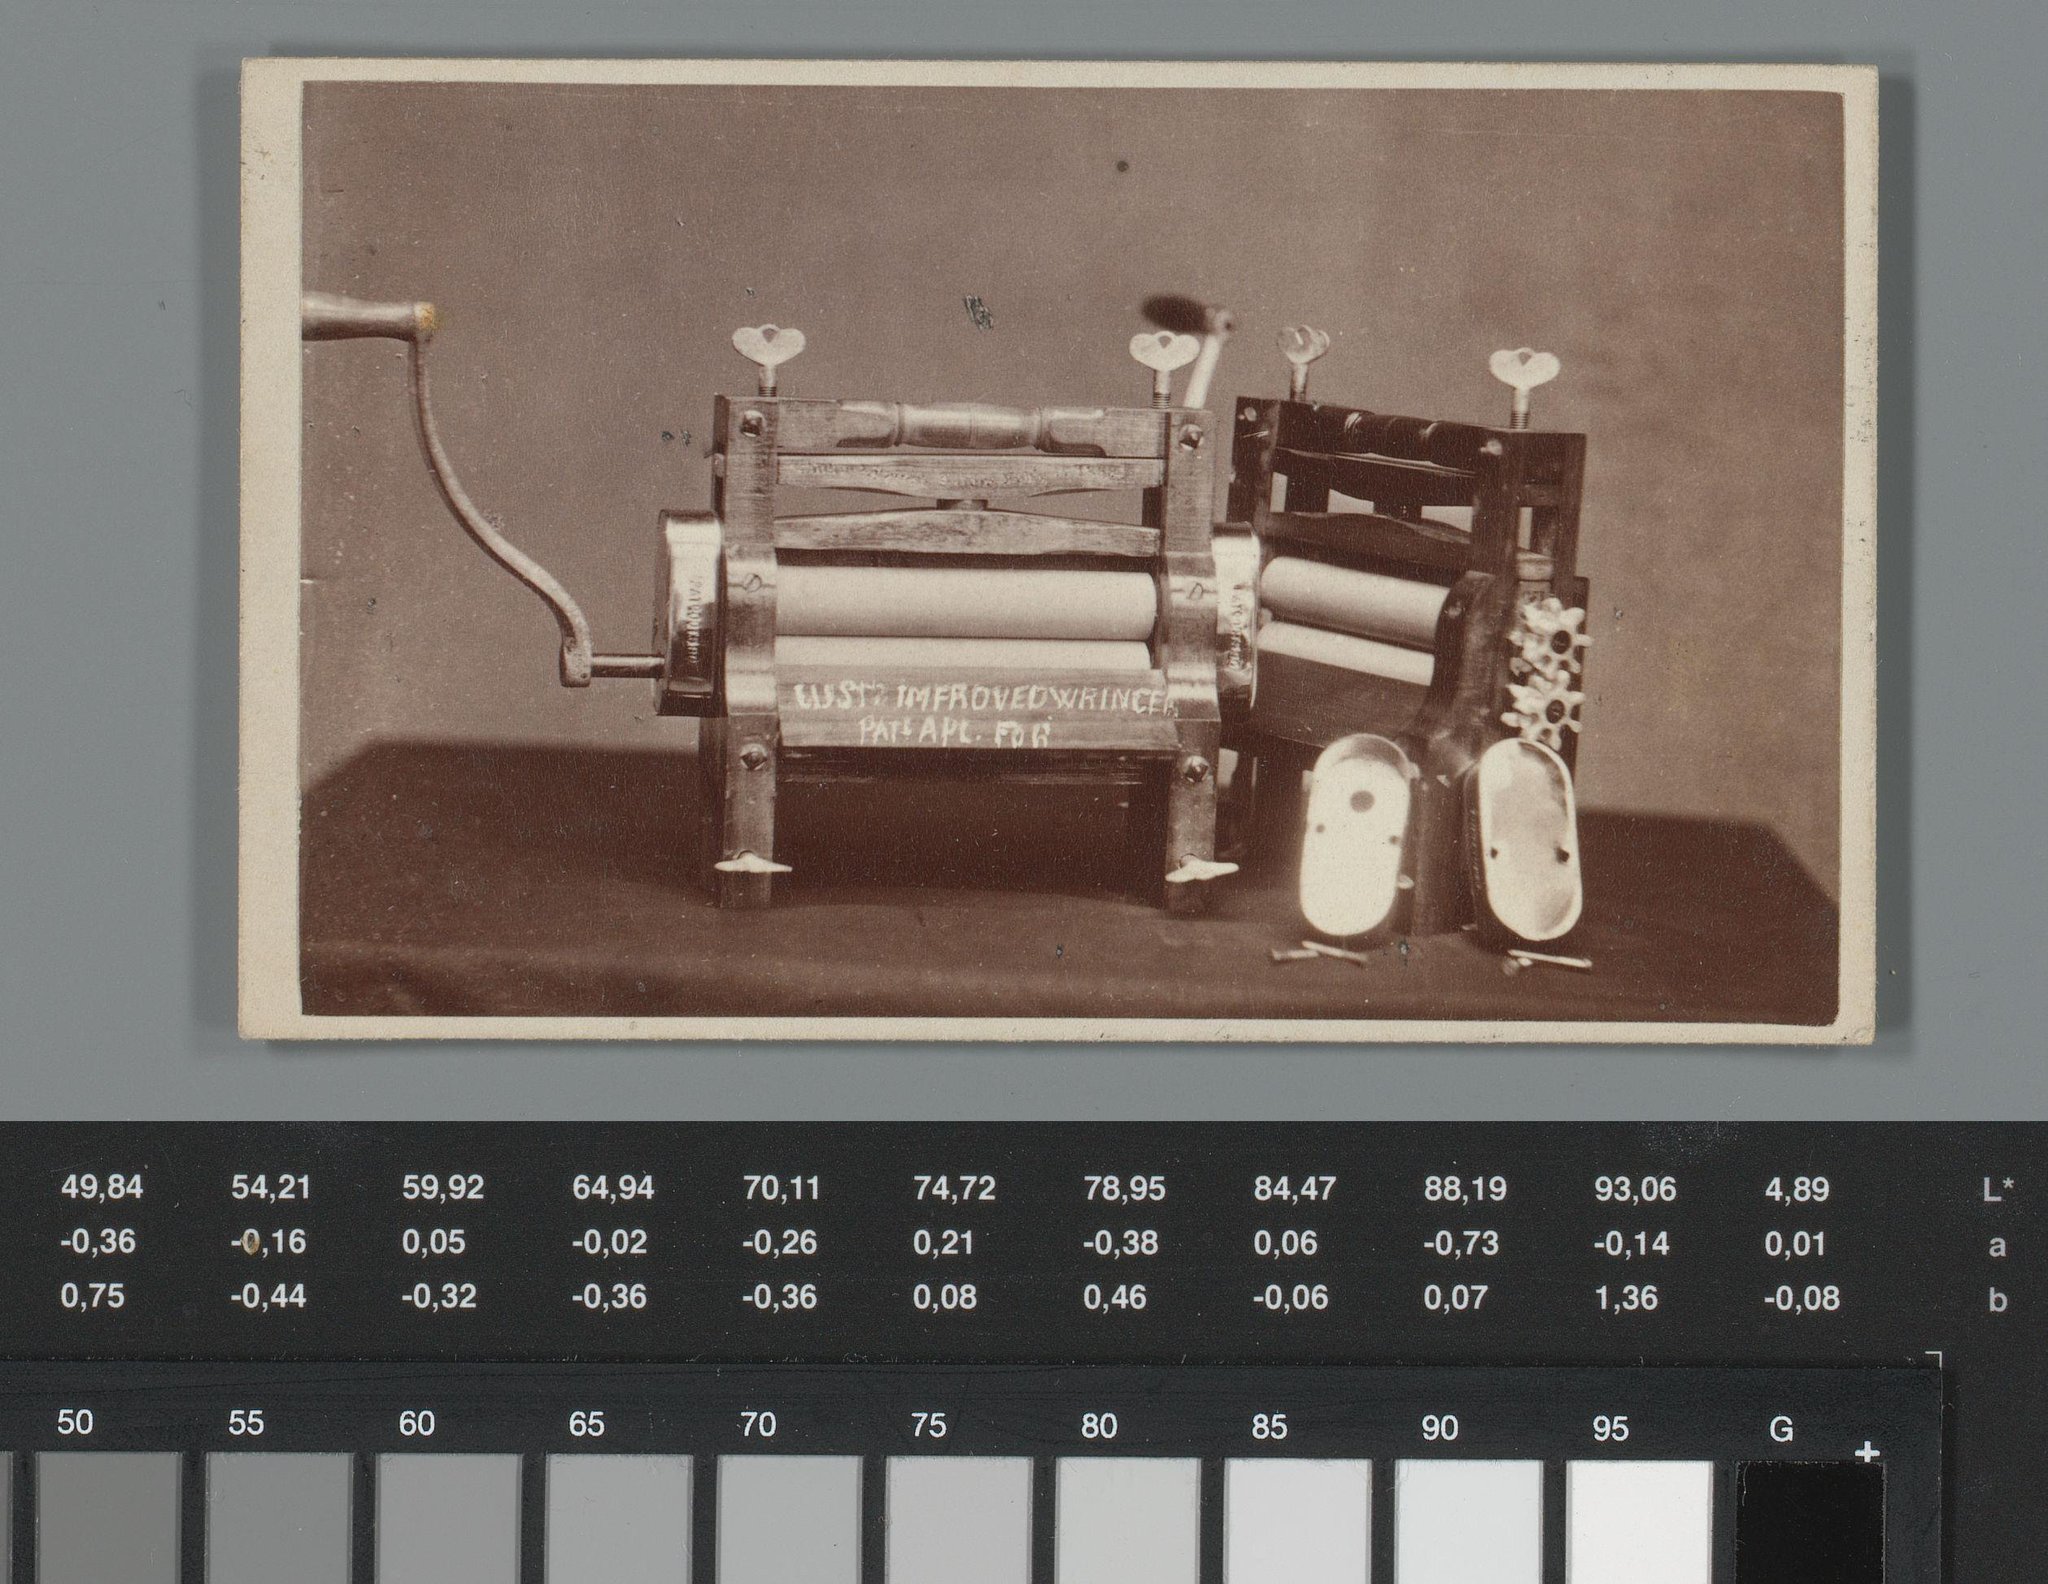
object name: carte de visite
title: Reclame voor een mangel van Just's Champion in Fauk City, Wisconsin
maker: p. j. schadde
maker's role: fotograaf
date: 1884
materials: cardboard, photographic support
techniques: carbon print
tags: tools, aids, implements ~ crafts and industries, advertising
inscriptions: inscription: ‘Fauk City, Wis. 1884/ (...)’